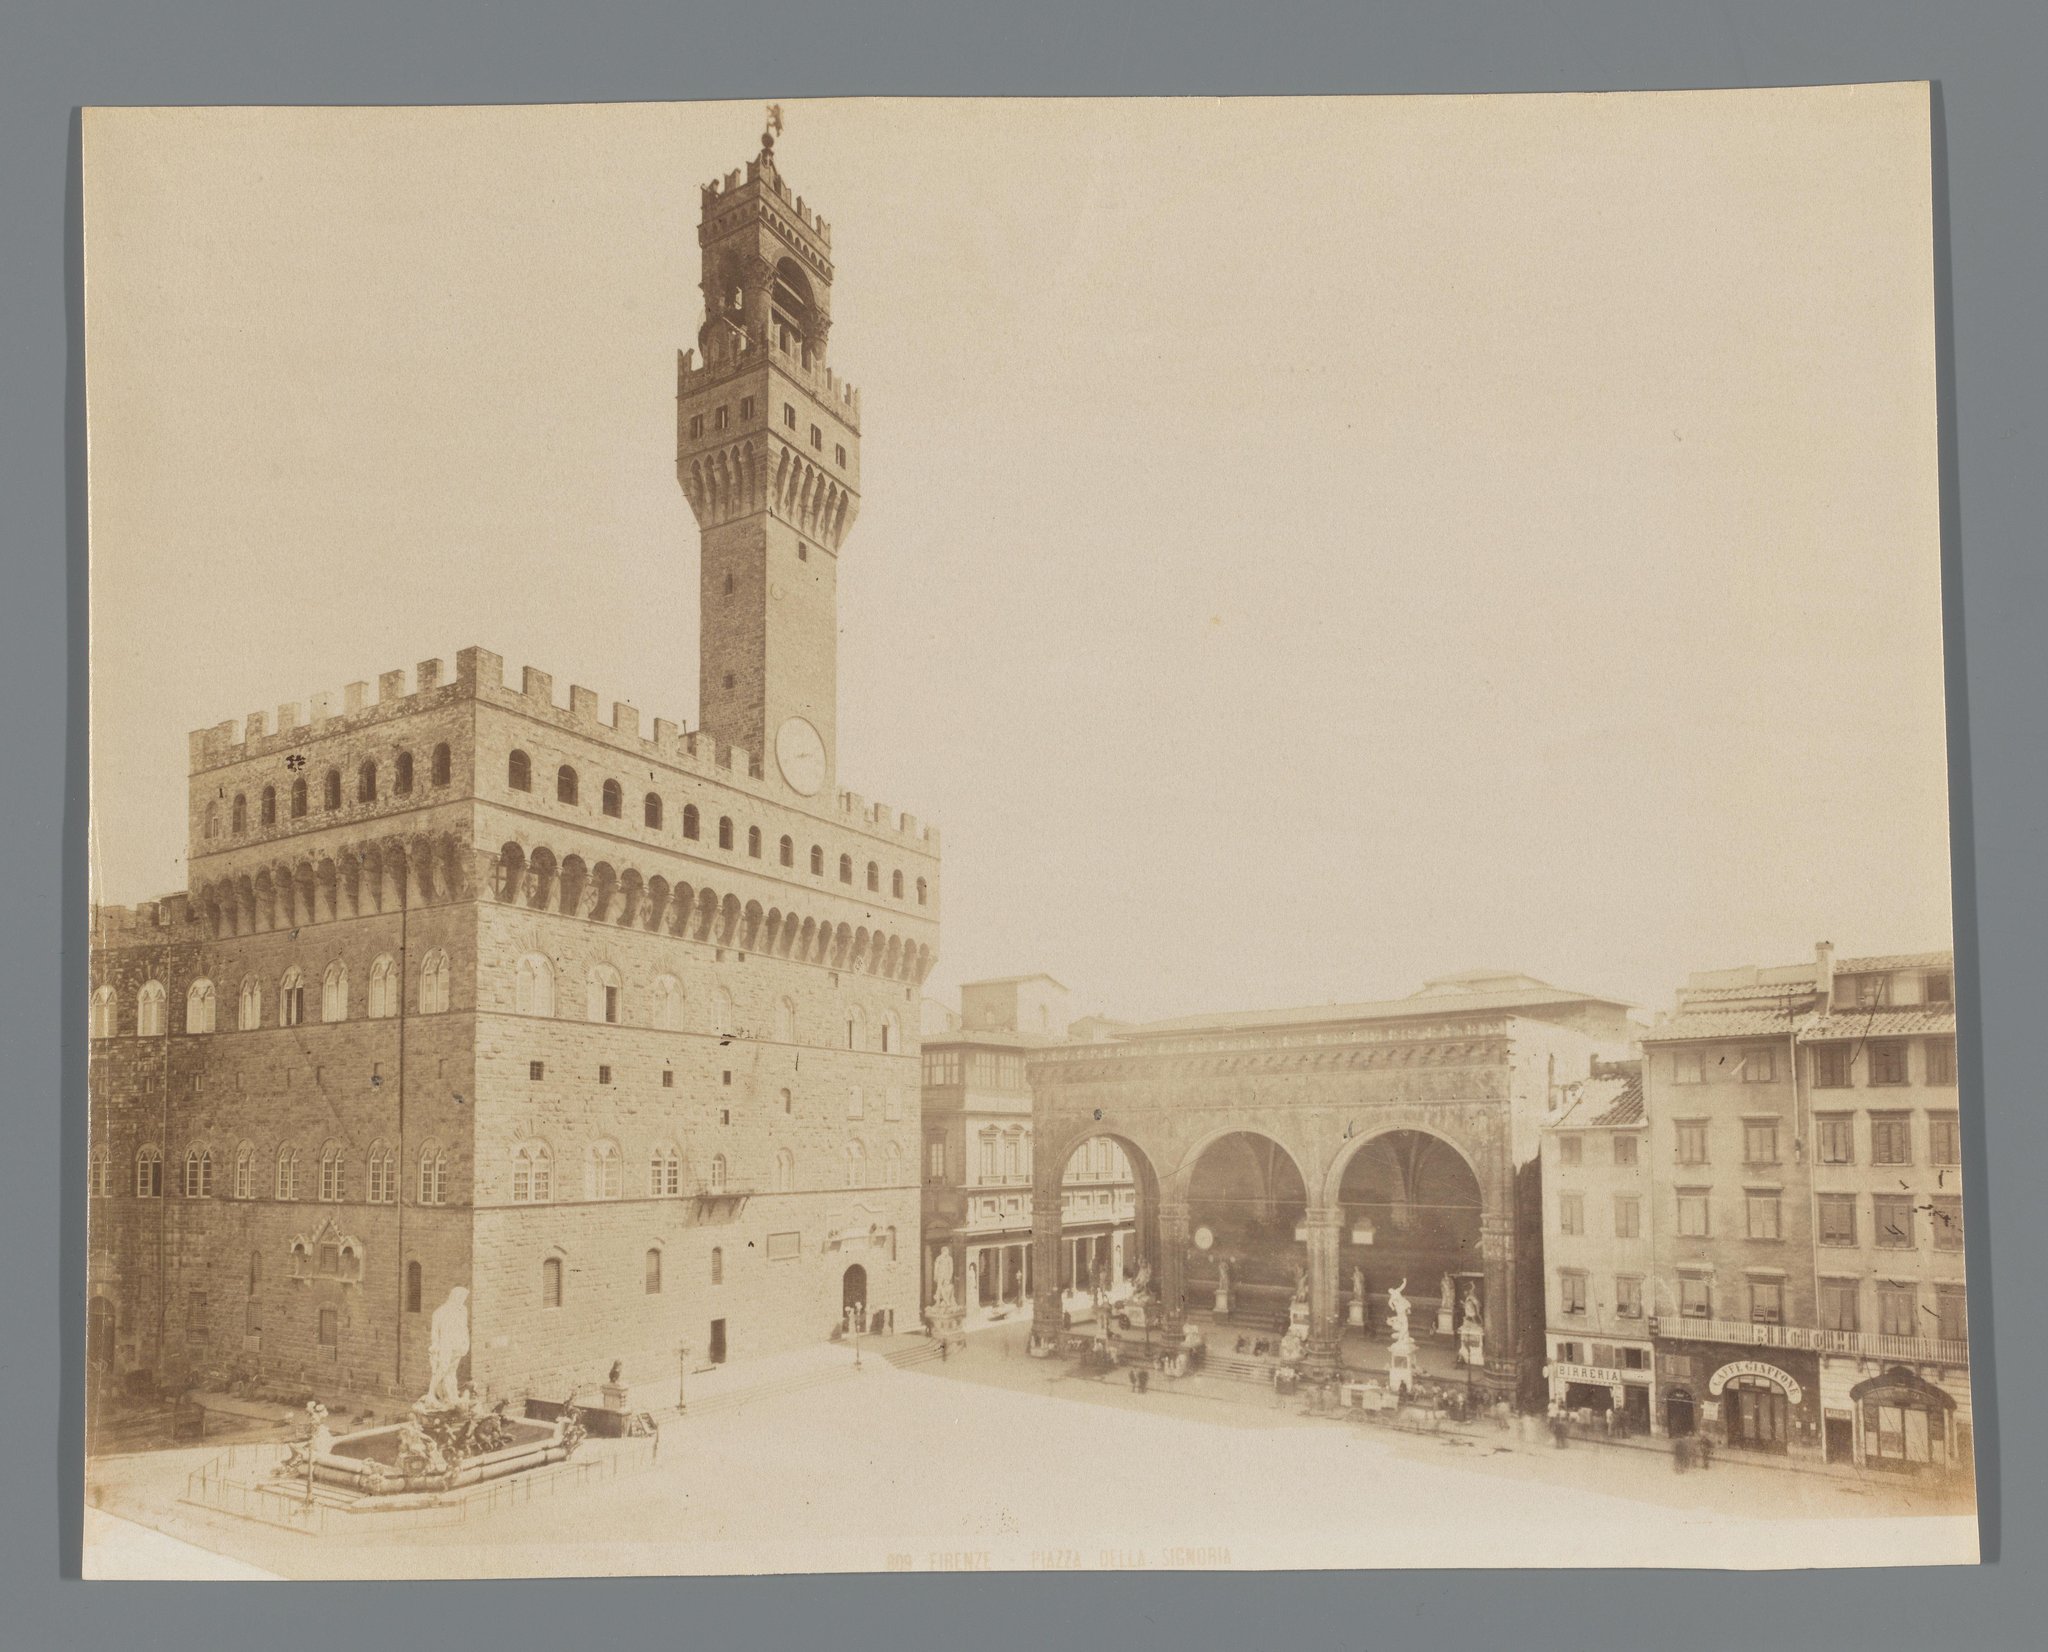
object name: photograph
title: Firenze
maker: Anonymous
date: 1851-1900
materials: paper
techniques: albumen print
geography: florence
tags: square, place, circus, etc., hôtel, i.e. small palace in city, loggia, verandah, porch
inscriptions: number: ‘809’, collector's mark: ‘VOSMAER’